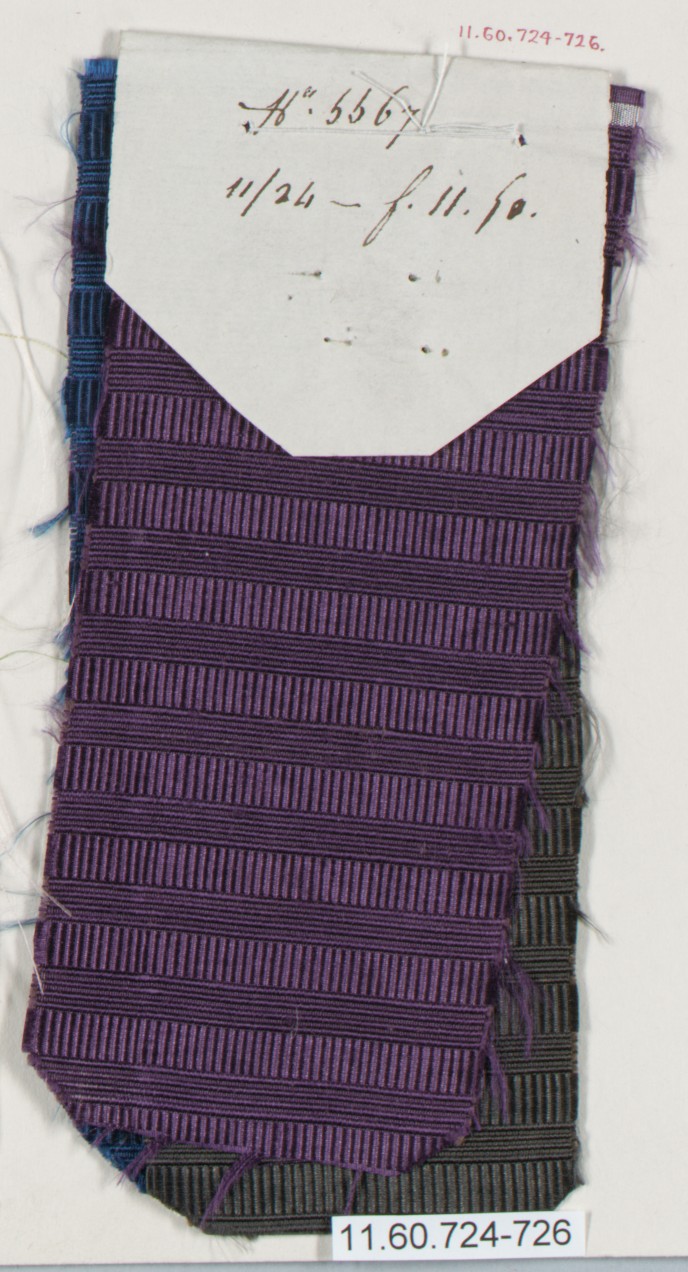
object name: sample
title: Samples (3)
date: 1801-1850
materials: silk